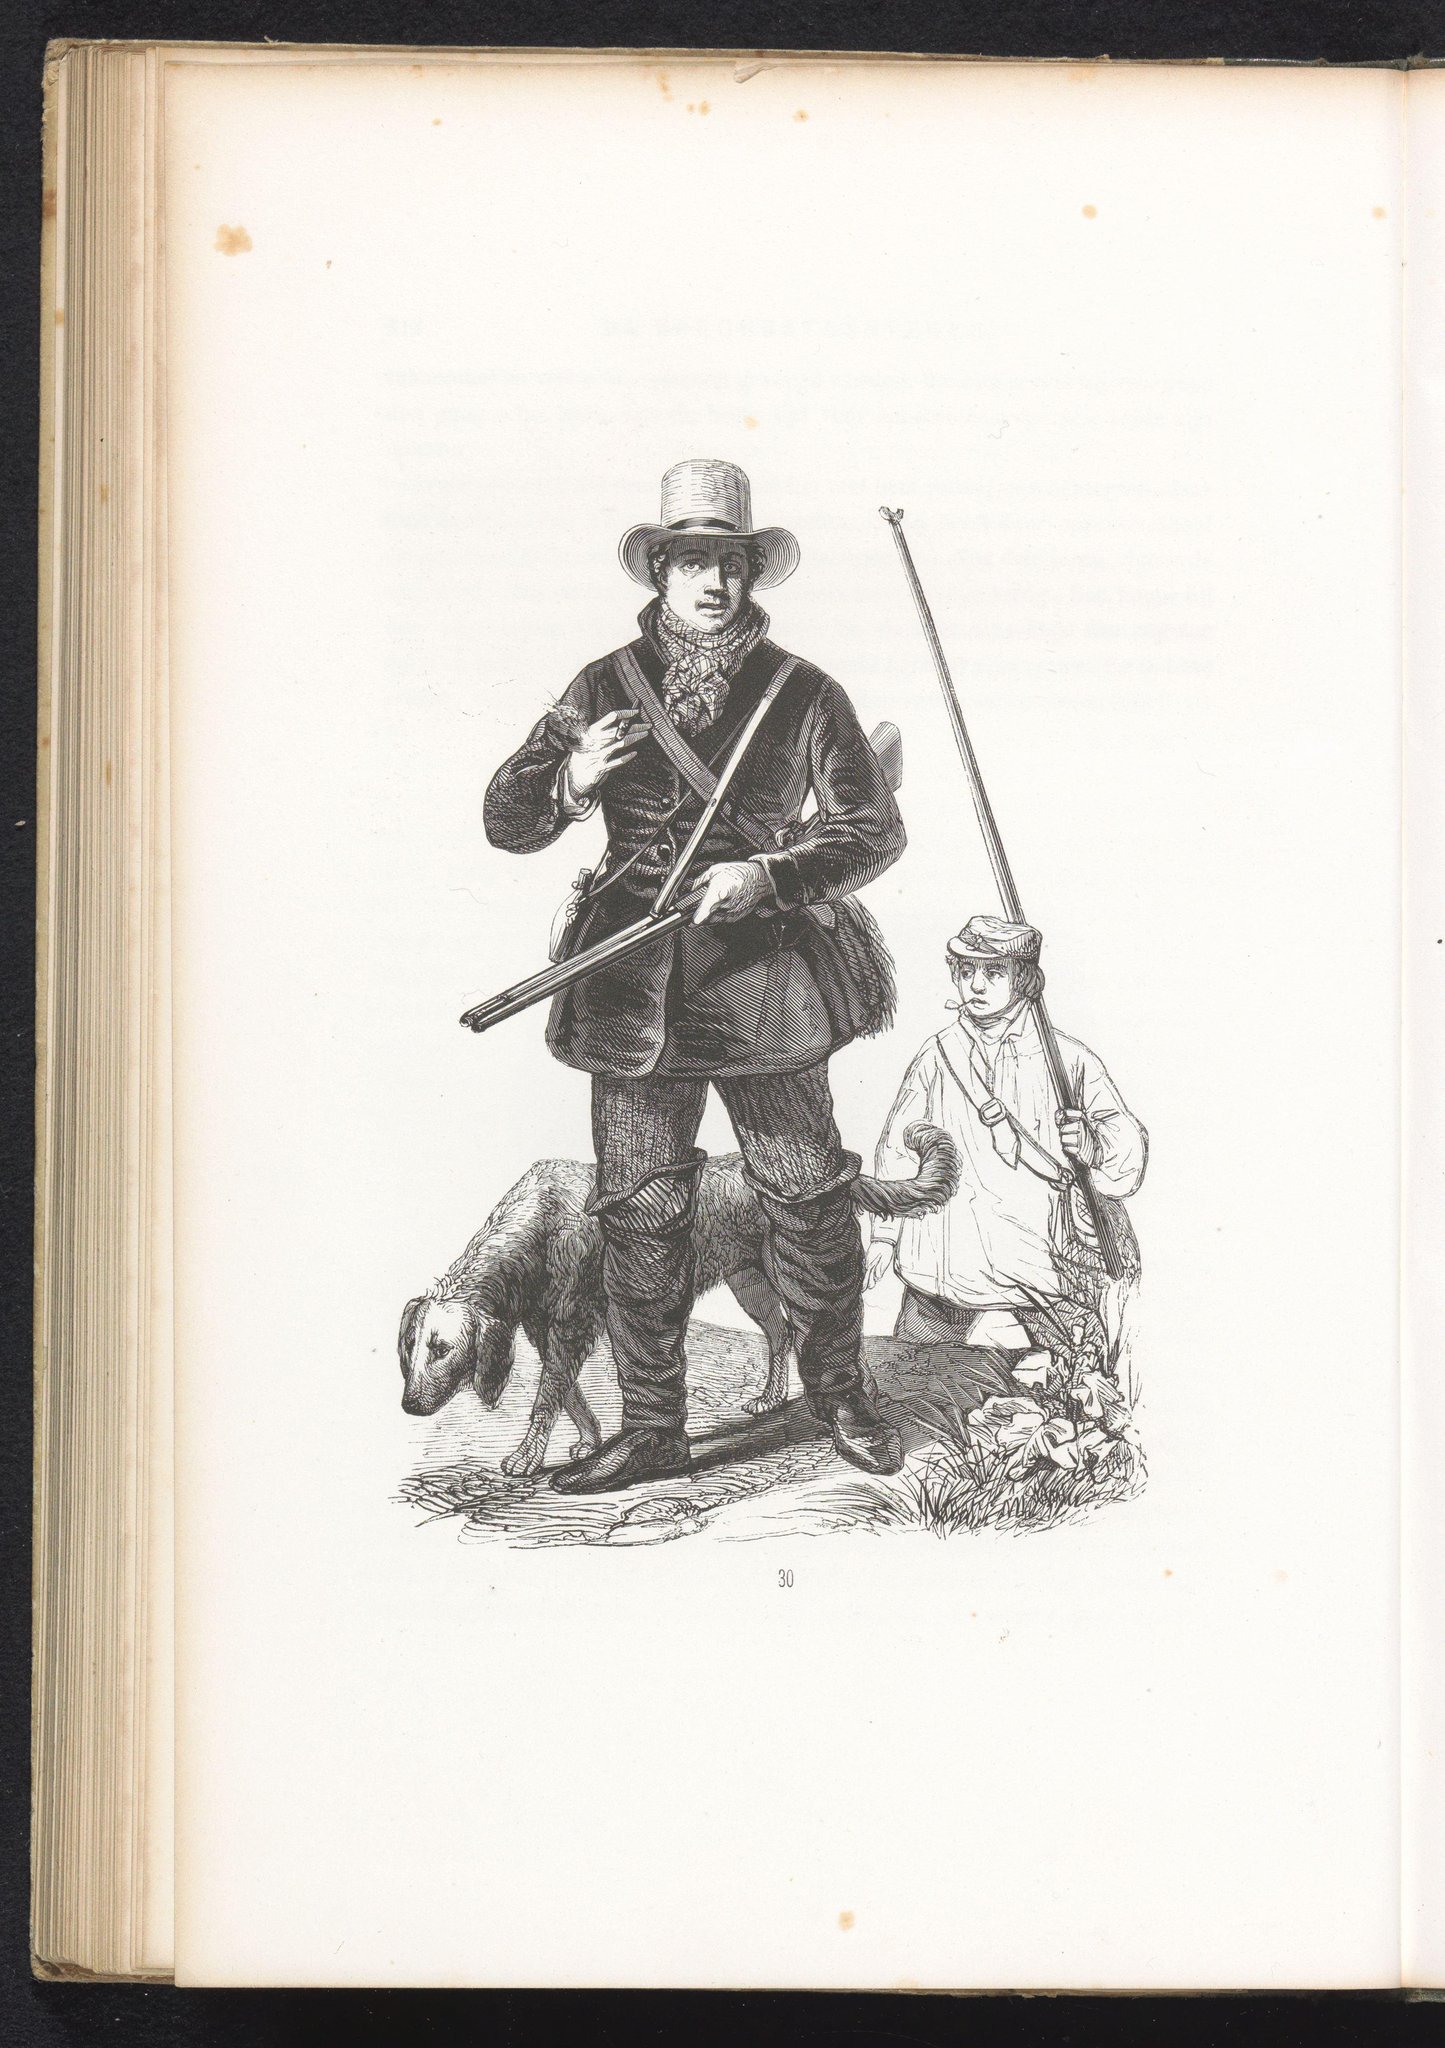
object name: book illustration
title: De liefhebberij jager, 1840-1841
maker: henry brown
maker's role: print maker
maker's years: 1816-1870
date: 1841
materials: paper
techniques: letterpress printing, engraving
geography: the hague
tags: professional clothes, hunters hunting (n.b.: in 1988-1990 this notation denoted the concept of 43c11421 'hunters resting during the hunt'), netherlands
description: De liefhebberij jager. Een jager met geweer, jachthond en begeleid door een knecht. Genummerd: 30. Illustratie in het boek 'De Nederlanden: karakterschetsen, kleederdrachten, houding en voorkomen van verschillende standen', een boek met karakterschetsen, beroepen en klederdrachten van Nederlandse volkstypen uit 1841.